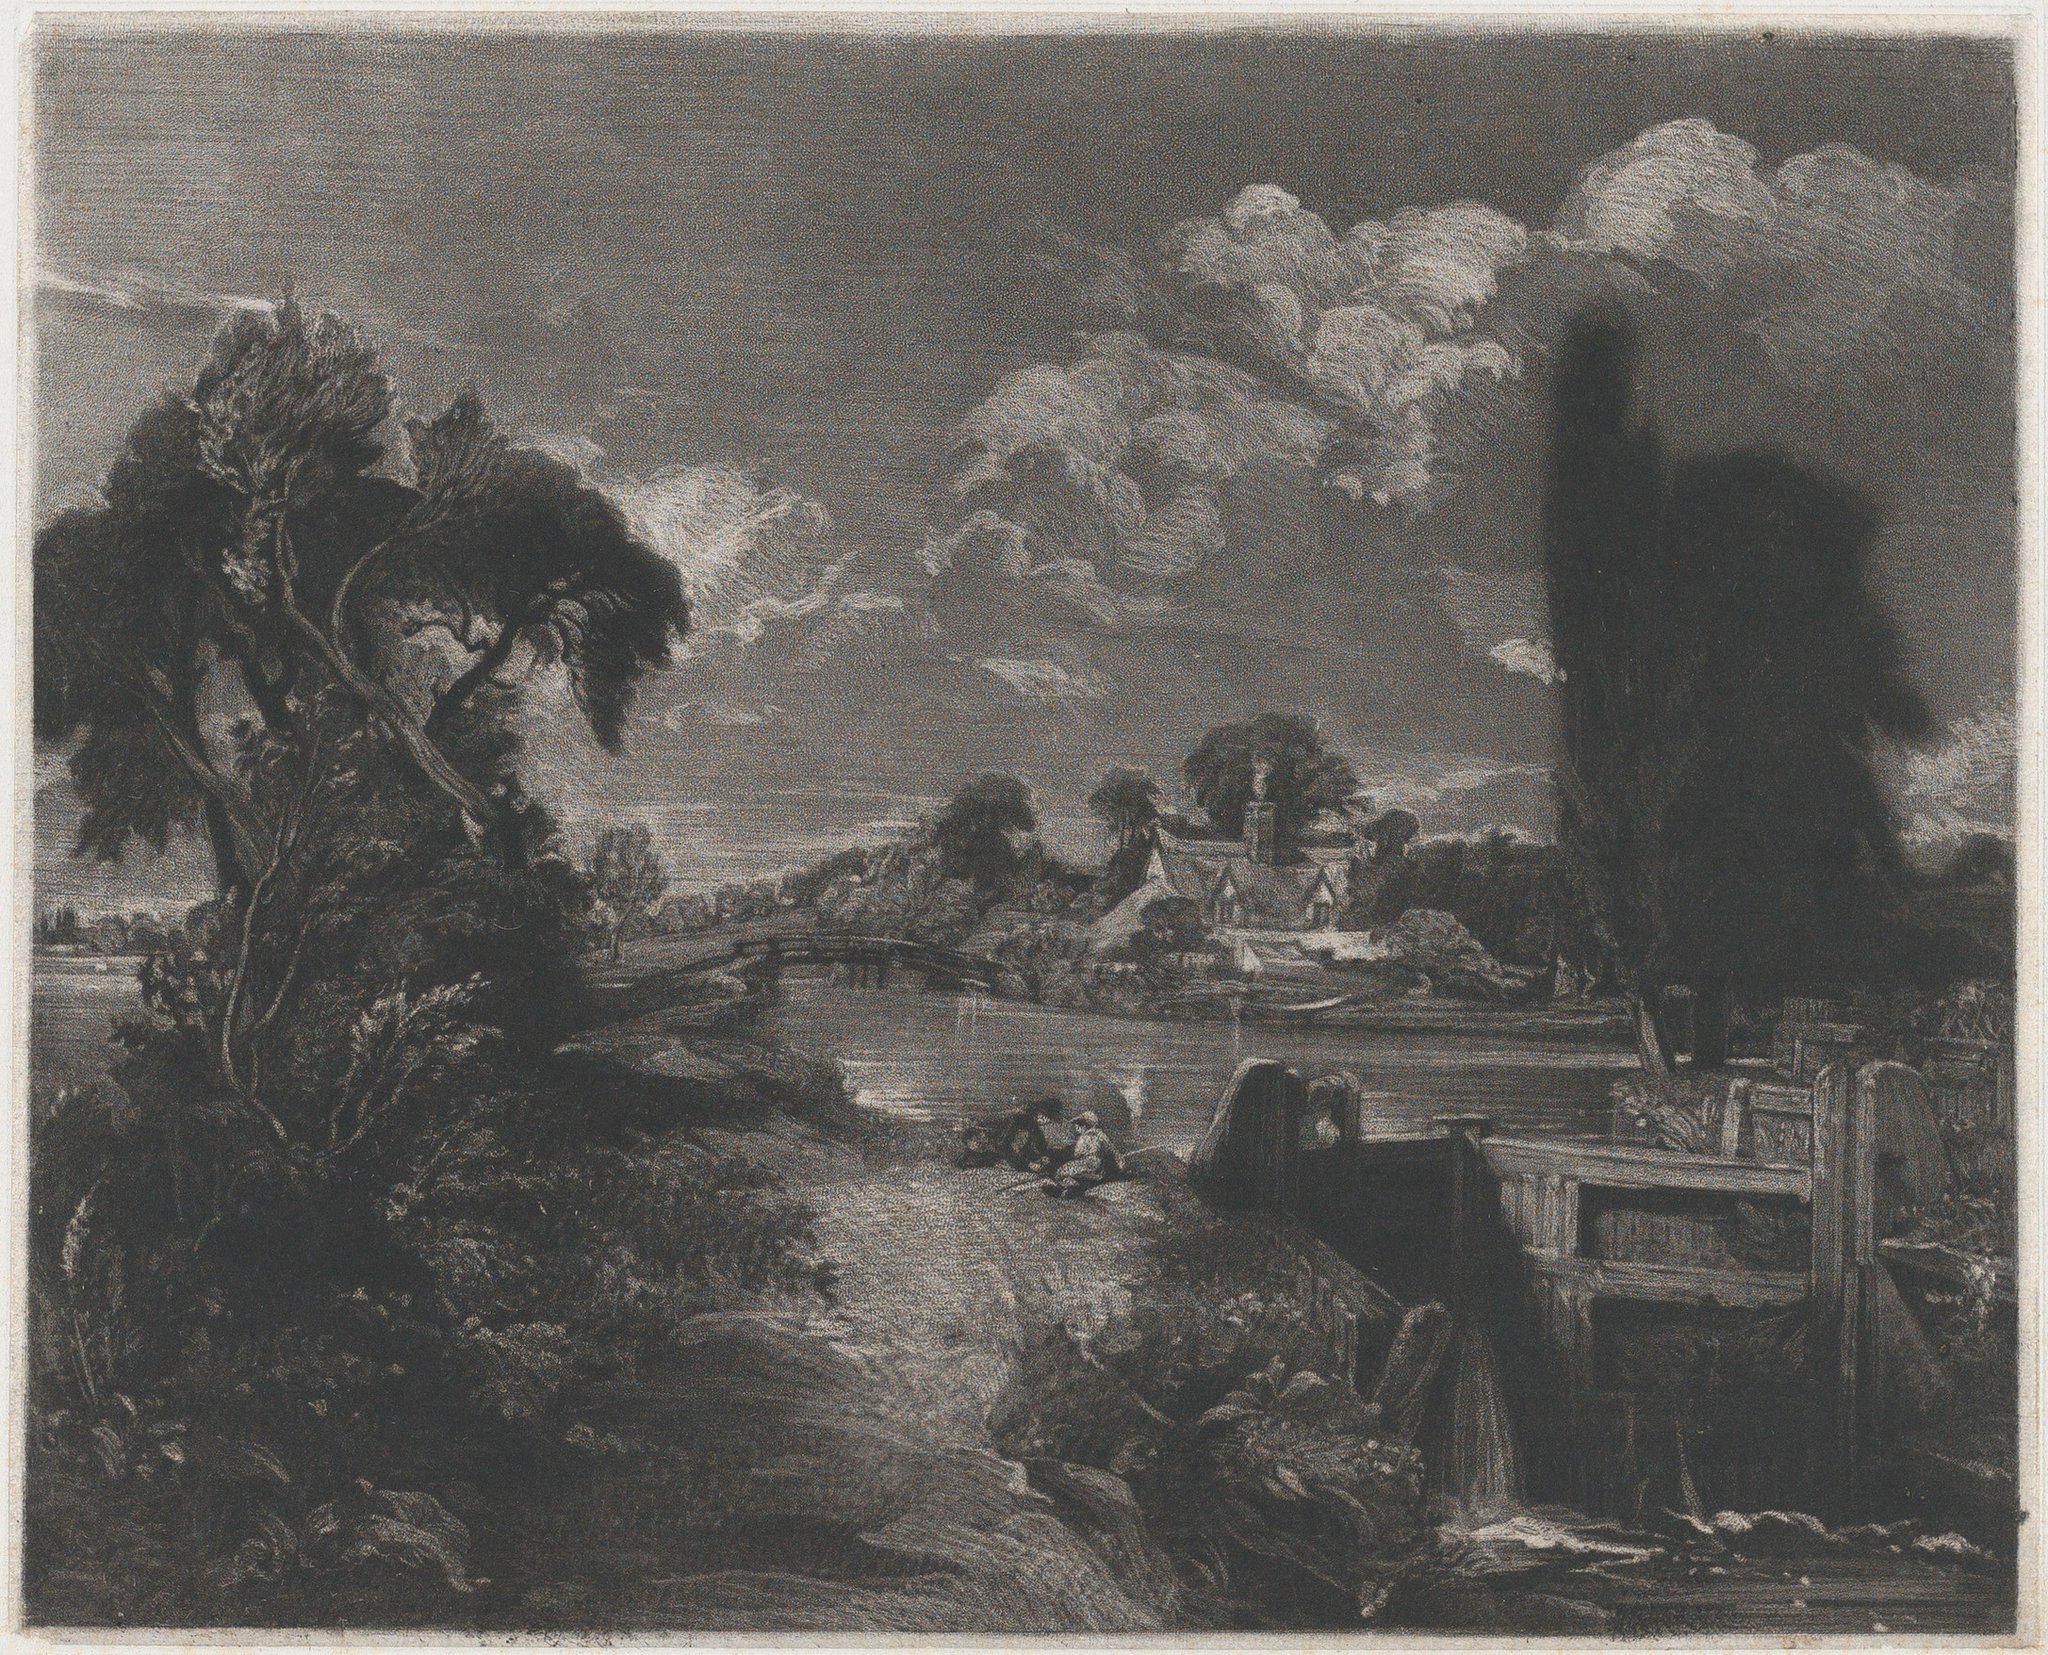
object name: print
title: A Lock on the Stour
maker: david lucas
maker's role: artist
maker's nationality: british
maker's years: 1802-1881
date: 1830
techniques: printmaking, mezzotint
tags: rivers,landscapes,trees